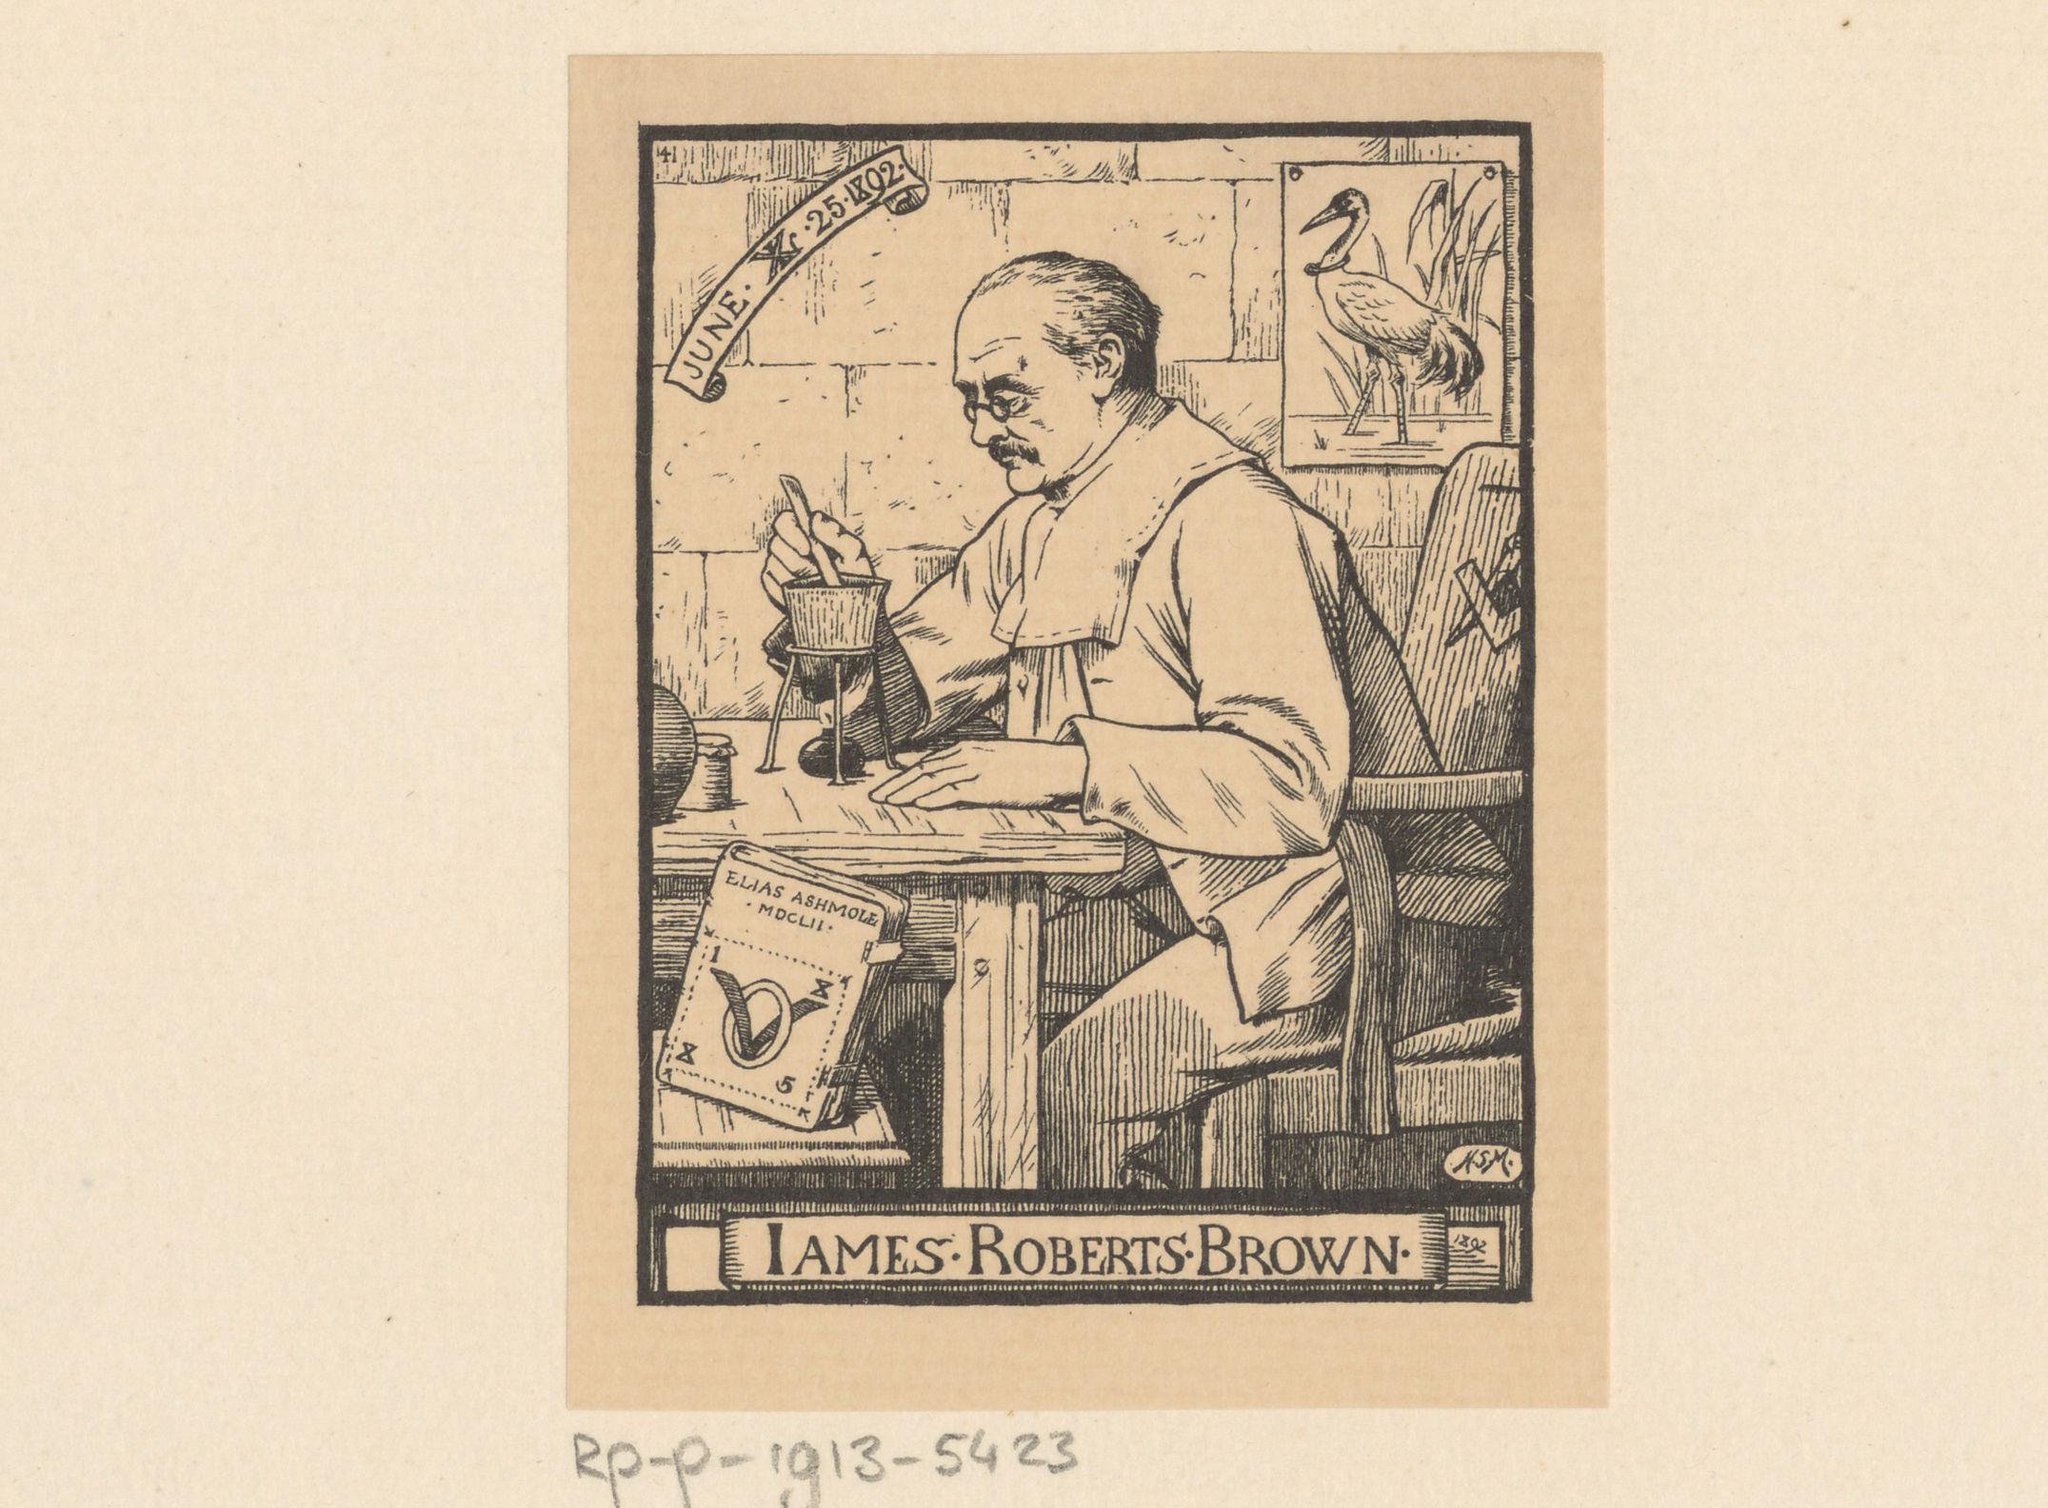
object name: bookplate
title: Ex libris van James Roberts Brown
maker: henry stacy marks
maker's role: artist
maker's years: 1829-1898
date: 1892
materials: paper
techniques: etching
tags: scholar in his study, miscellaneous religions, cults and doctrines: freemasonry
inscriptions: collector's mark: Lugt 2760, collector's mark: Lugt 2233